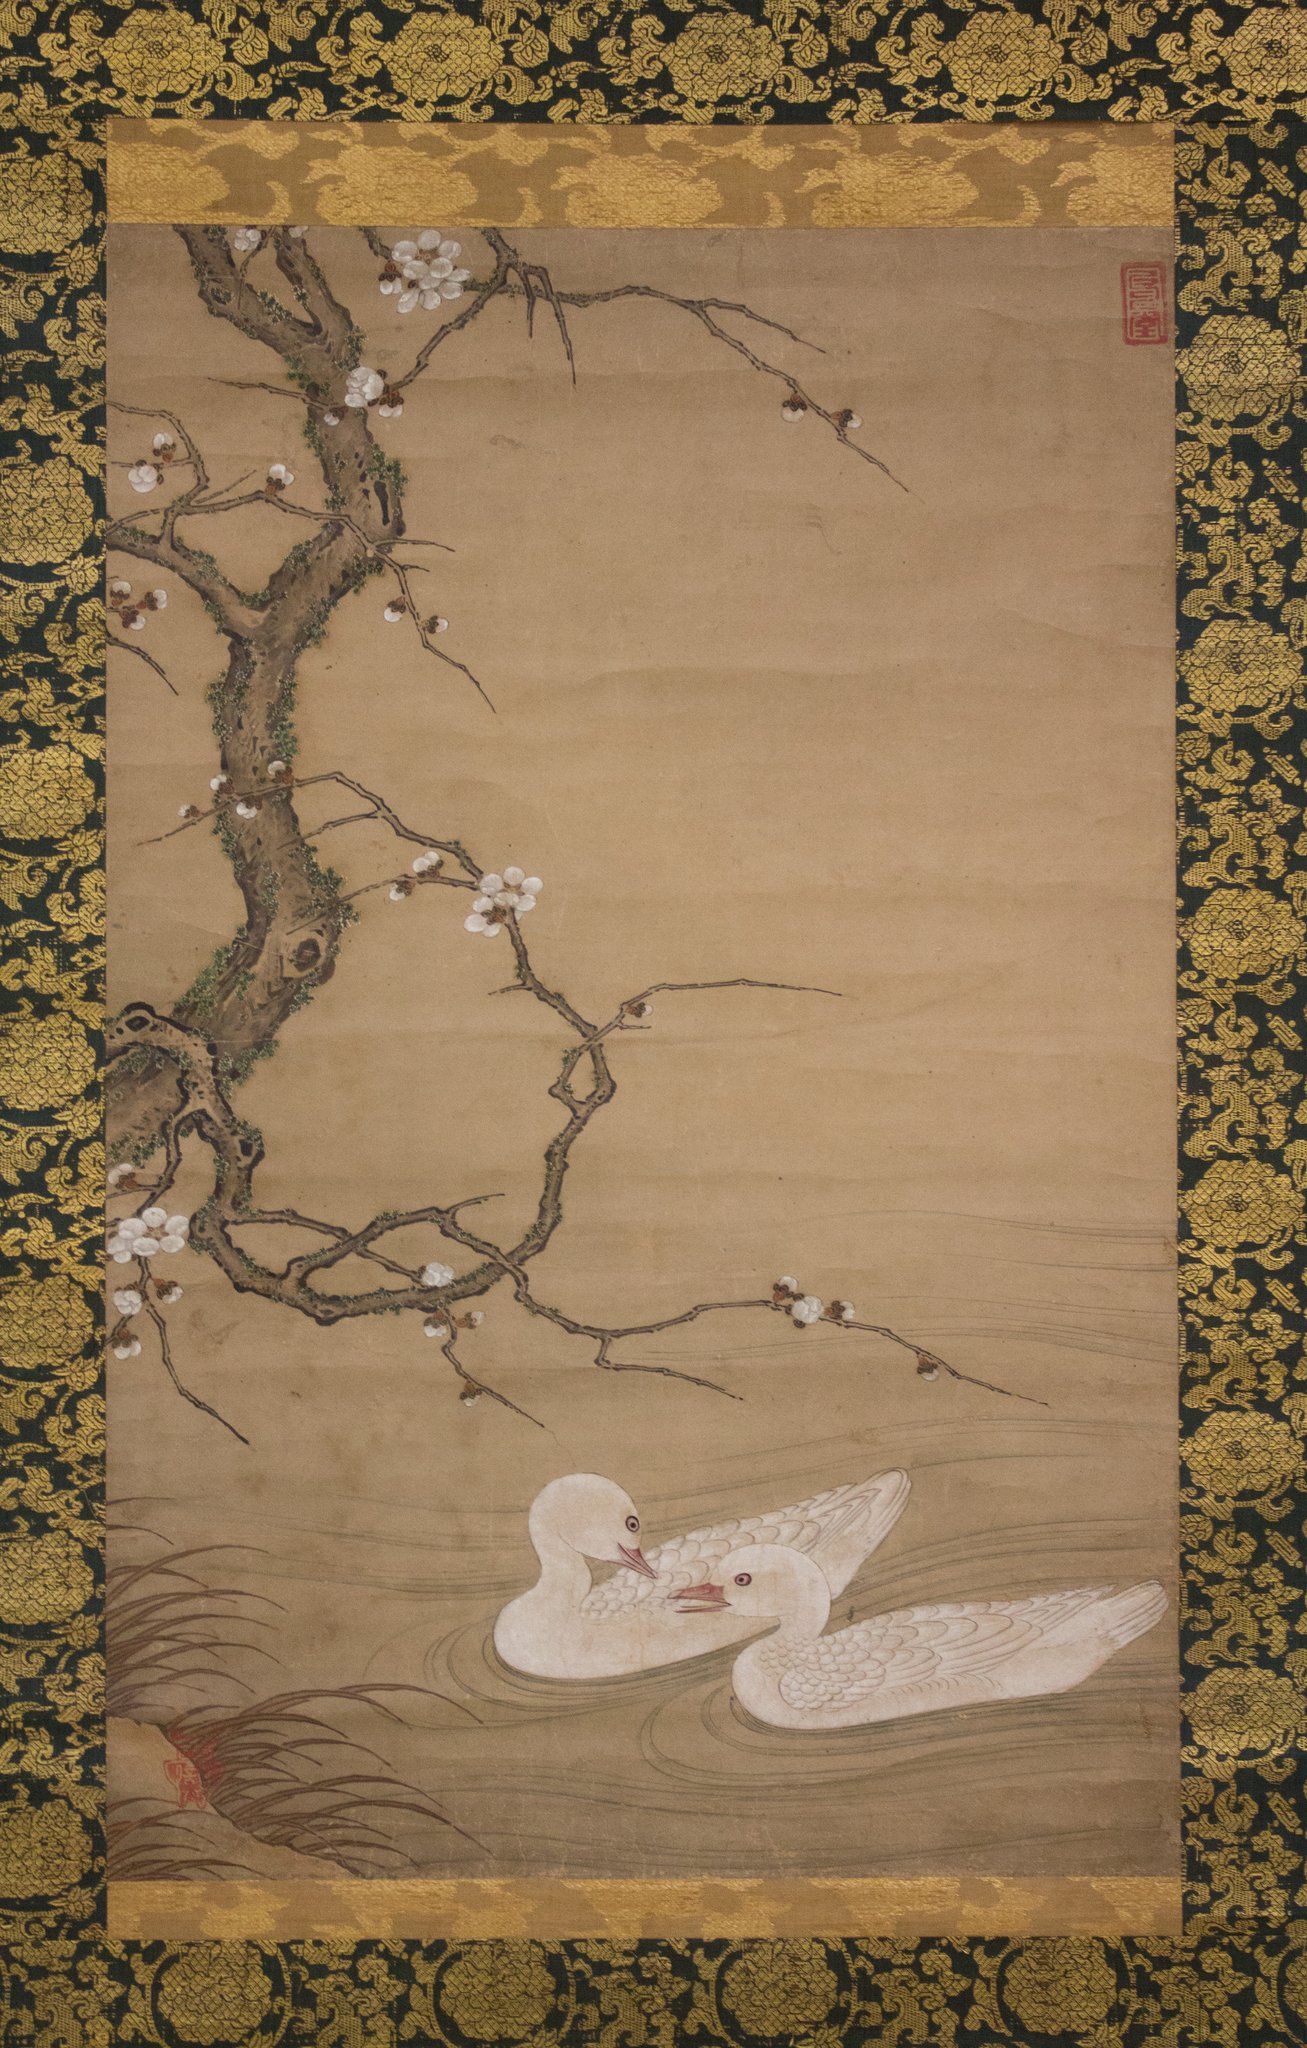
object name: hanging scroll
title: Plum Tree and Waterfowl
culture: japanese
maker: kano masanobu 狩野正信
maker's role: artist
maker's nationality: japanese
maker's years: 1434-1530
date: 1501-1533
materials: ink, paper